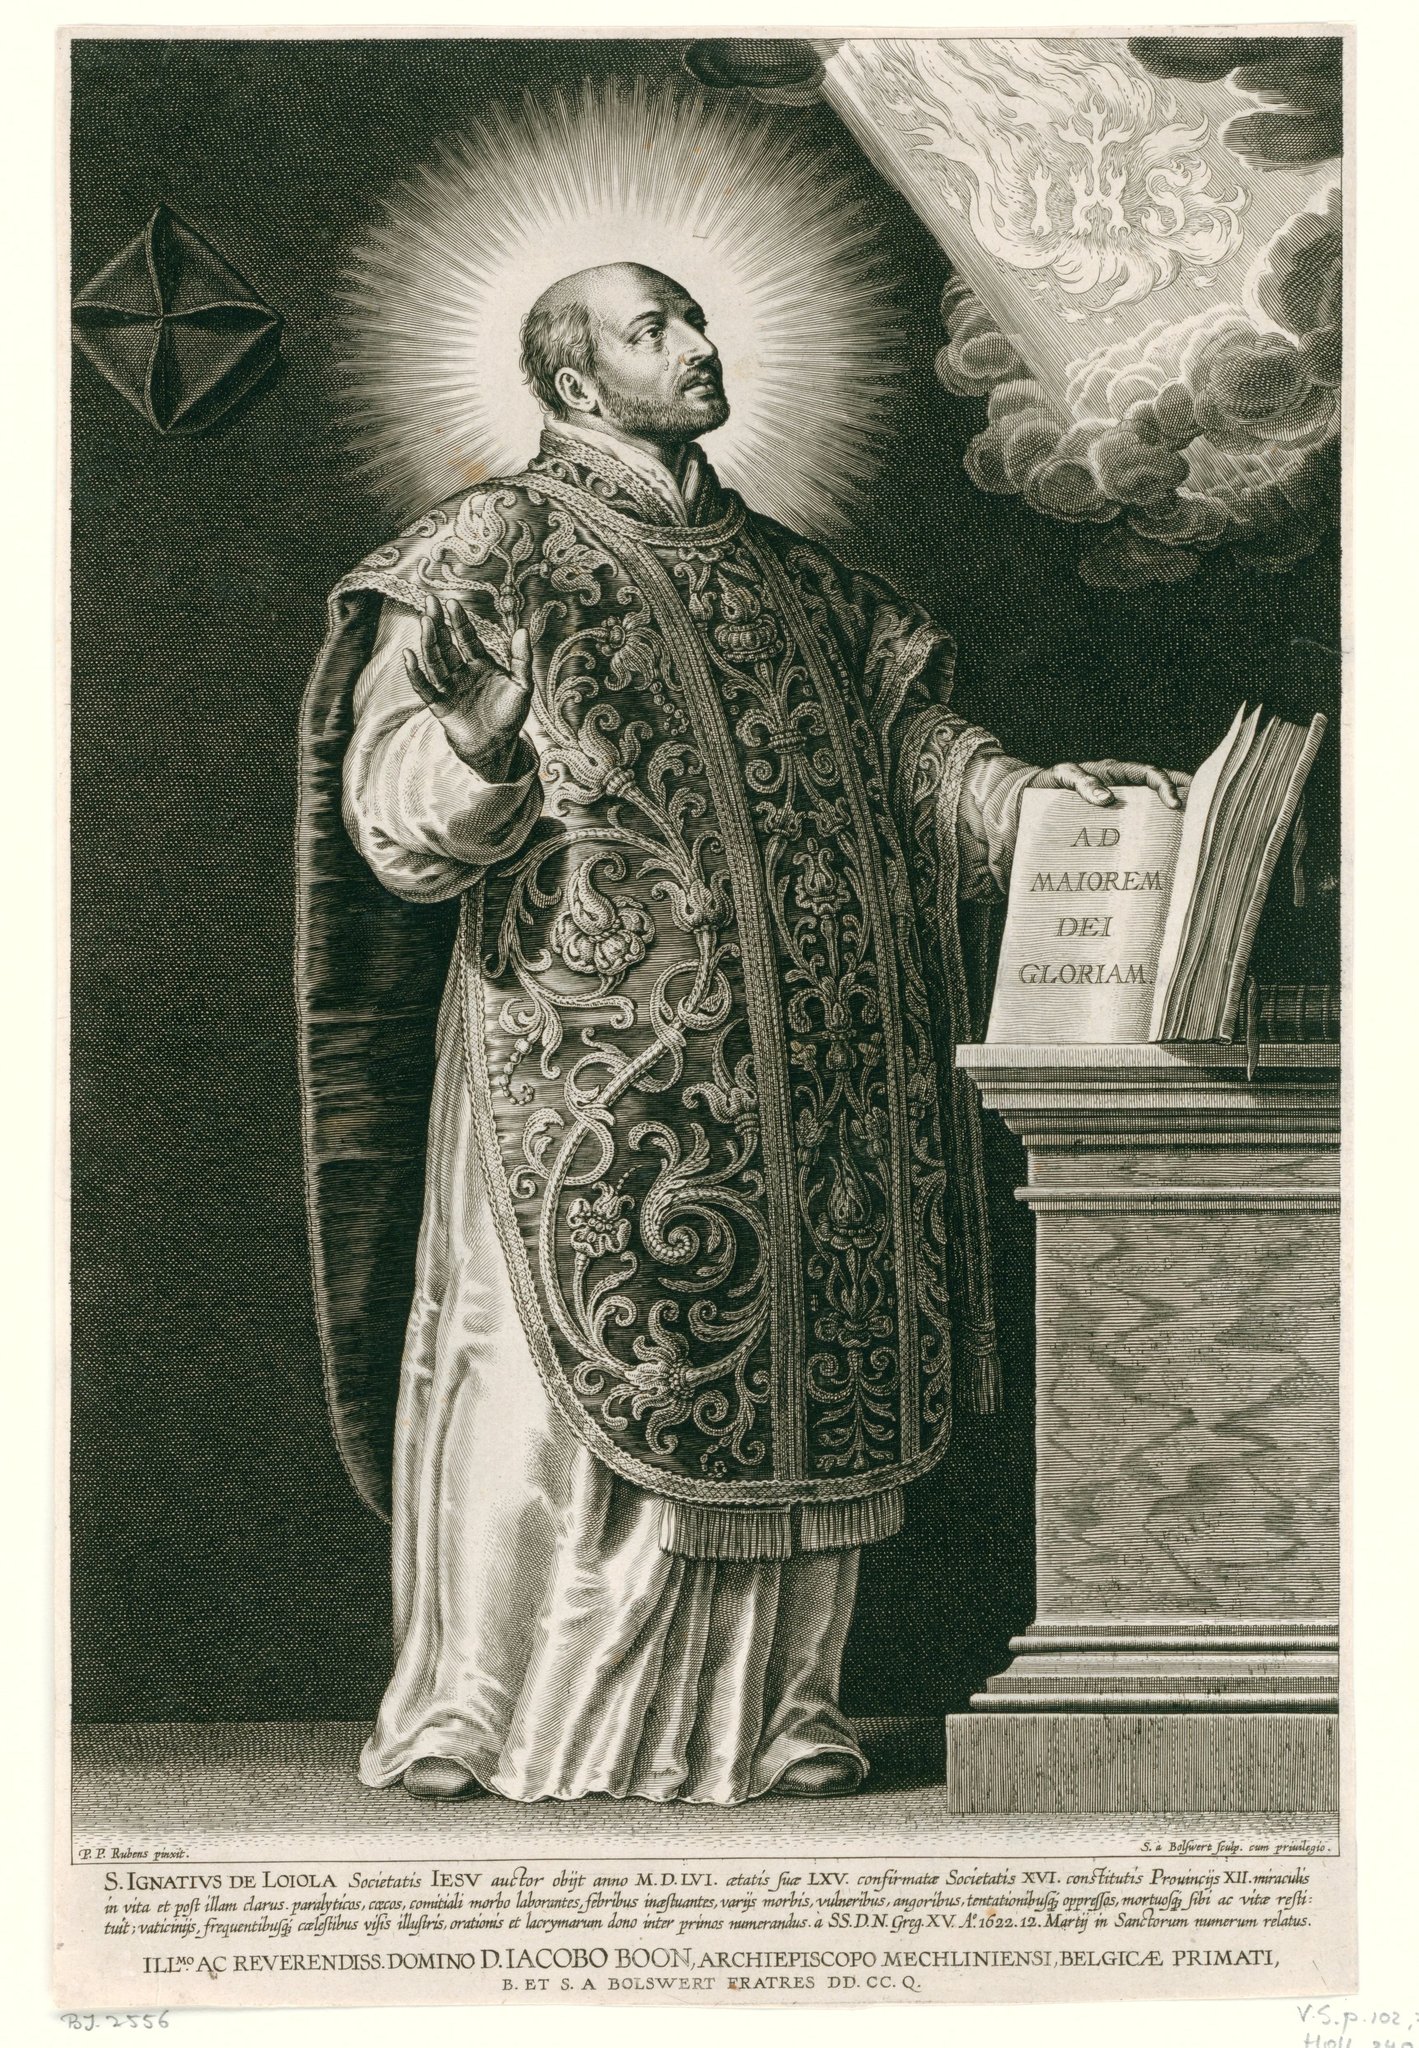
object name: print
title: Heilige Ignatius van Loyola met monogram IHS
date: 1622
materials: paper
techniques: engraving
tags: ihs ('iesus hominum salvator') ~ symbol of christ, the founder of the jesuit order, ignatius of loyola; possible attributes: book (with 'ad majorem dei gloriam'), demon, dragon under feet, flames, flaming heart, globe, ihs monogram, skull (with crown), tears in eyes, torch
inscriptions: collector's mark: Lugt 2228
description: Ignatius van Loyola als een man van middelbare leeftijd, kalend met een korte, donkere baard. Zijn hoofd is omgeven door een aureool, een paar tranen rollen uit het rechteroog. Zijn kazuifel is rijk geborduurd. De rechterhand is opgeheven, de linkerhand rust op zijn attribuut: een opengeslagen boek met het opschrift Ad majorem Dei Gloriam (Tot meerdere eer van God), de aanvangswoorden van de regel der jezuïeten. Rechtsboven, boven een aantal wolken, verschijnen in een stralenbundel de letters IHS, het monogram van de orde. Onder de voorstelling staat een tekst met de verdiensten van de heiligen.